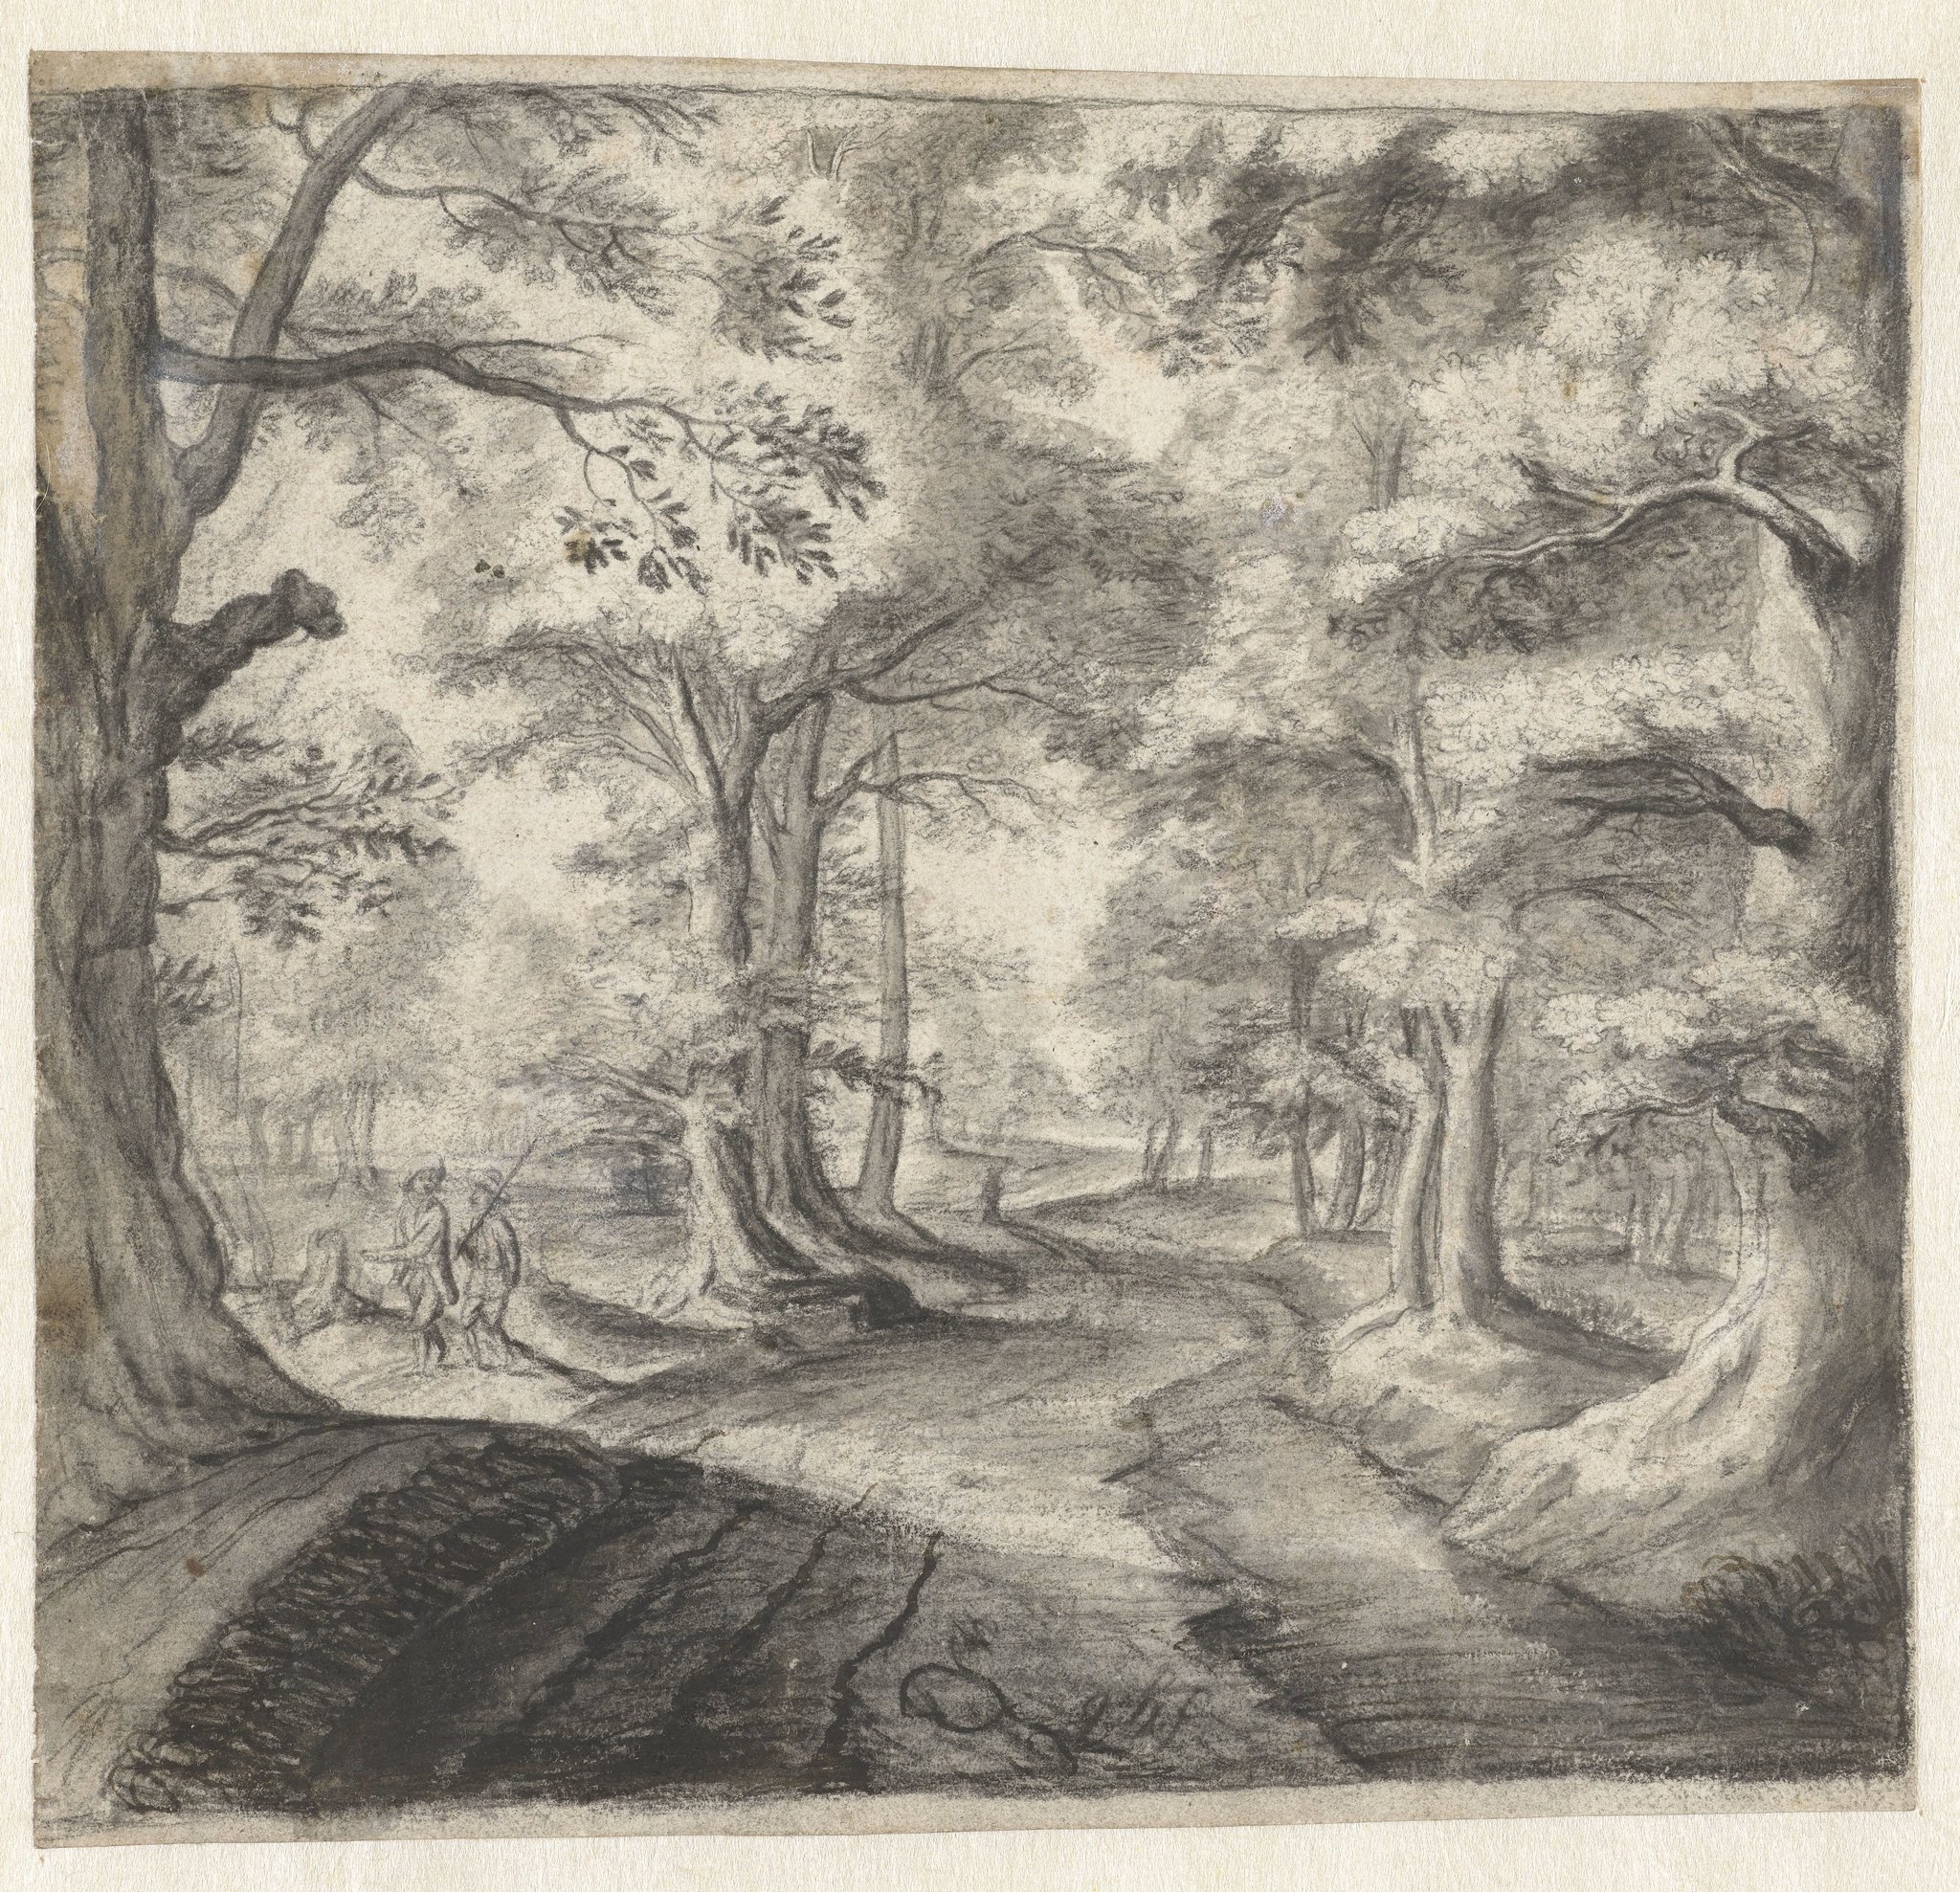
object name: drawing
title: Bosgezicht met twee jagers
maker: monogrammist gh (tekenaar ; 17e eeuw)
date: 1600-1699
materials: chalk, paper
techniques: brush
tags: forest, wood